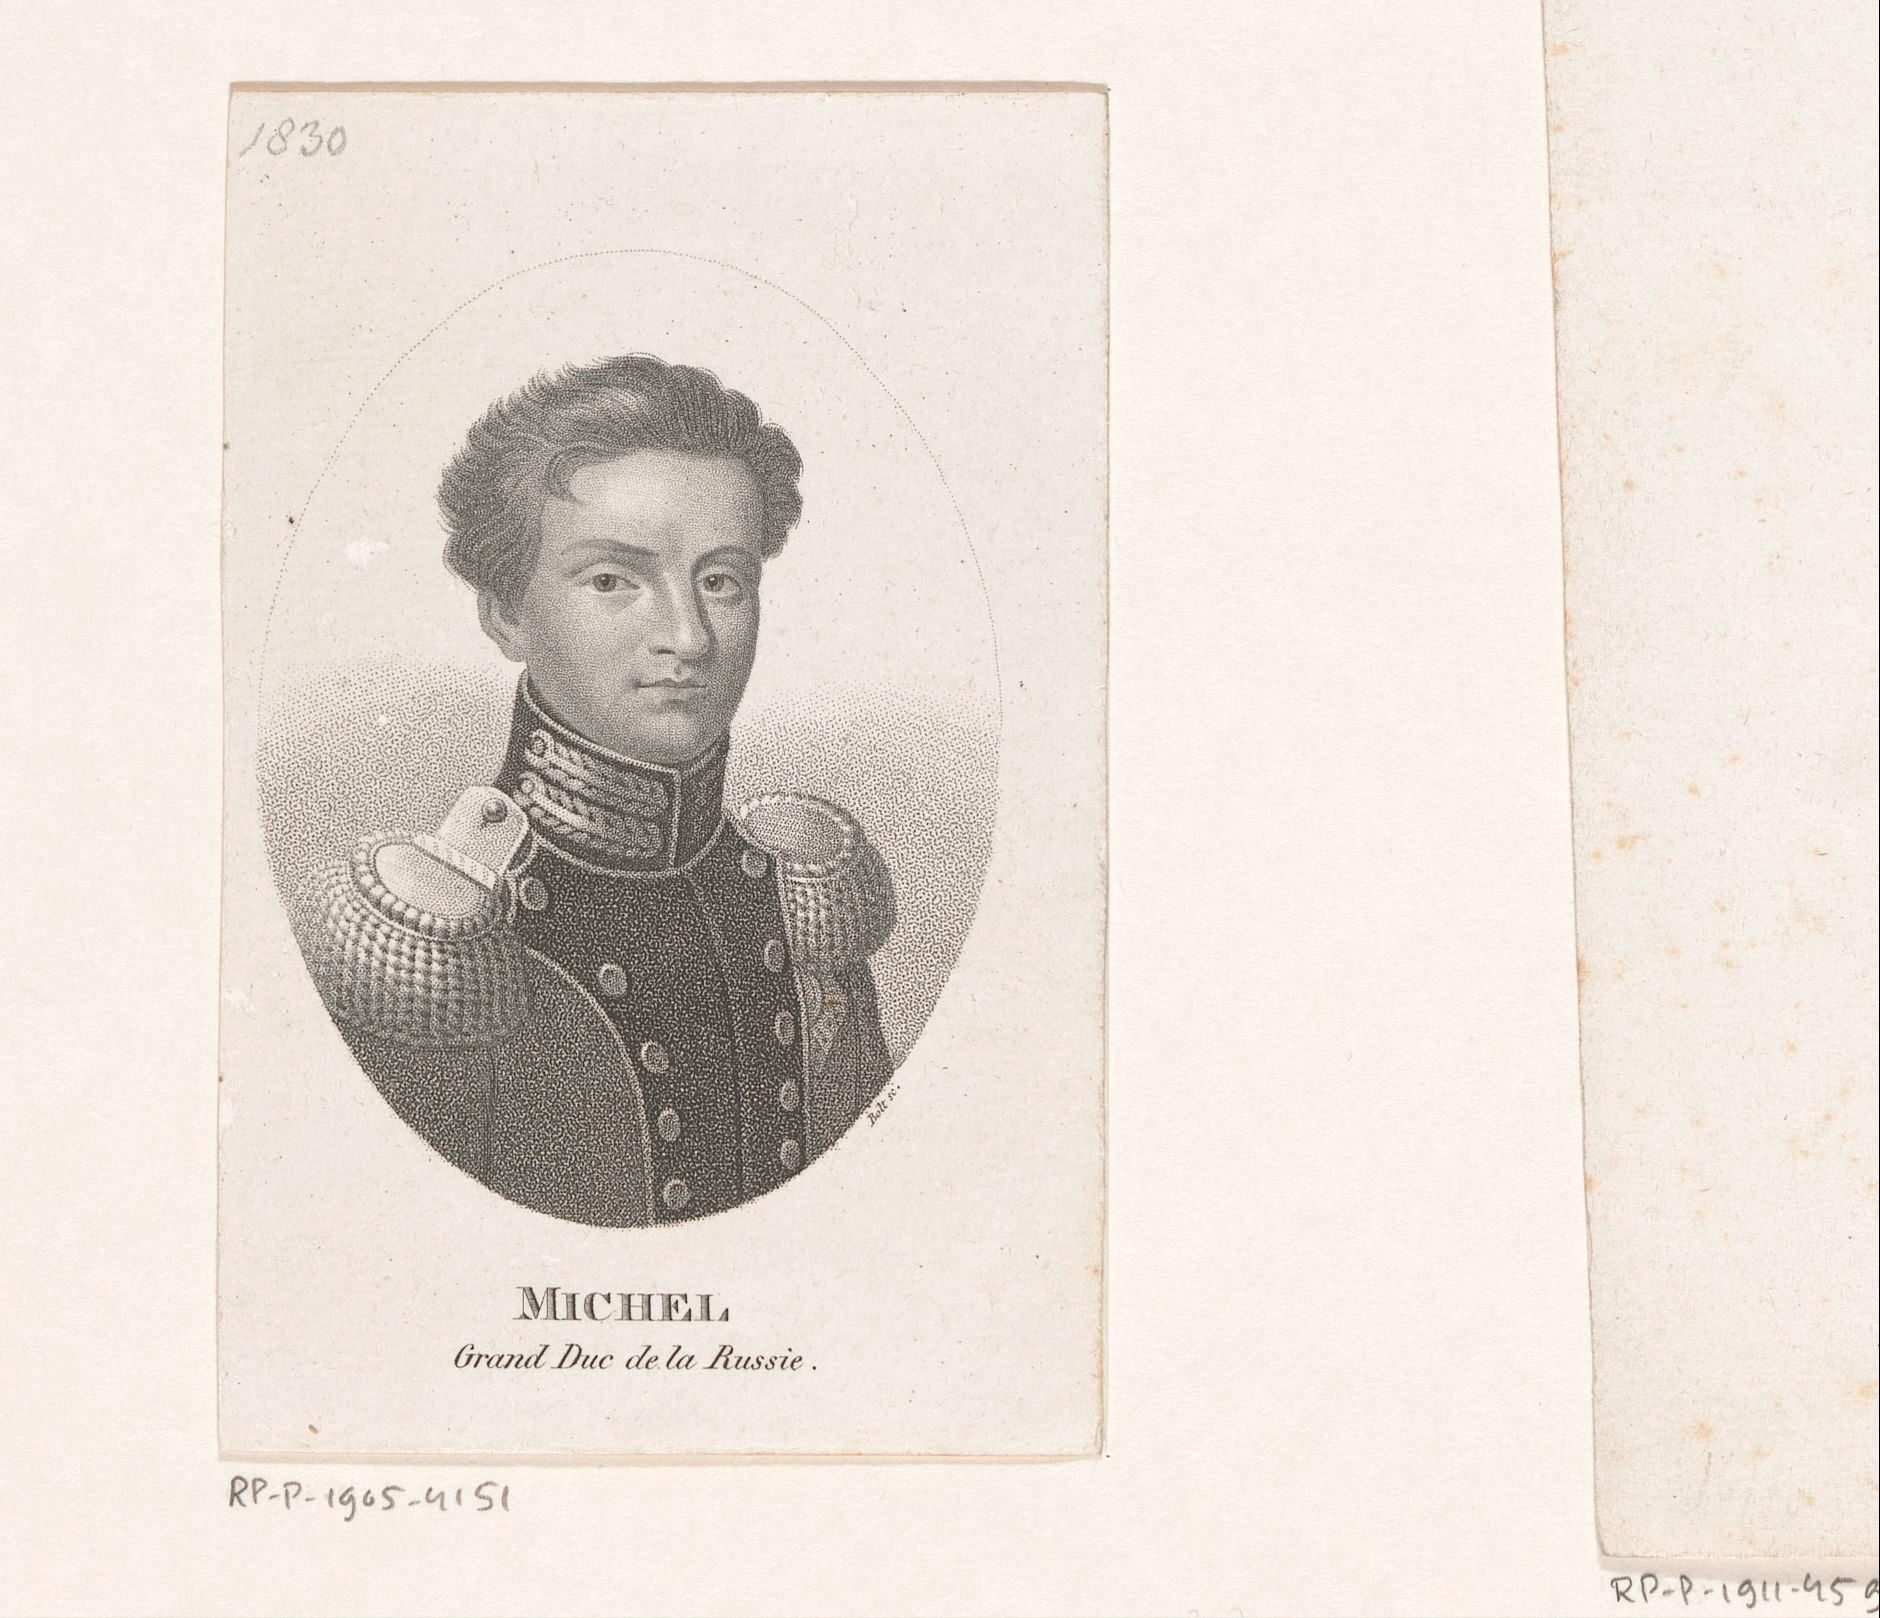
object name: print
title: Portret van Michaël Pavlovitsj, grootvorst van Rusland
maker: johann friedrich bolt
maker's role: print maker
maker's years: 1769-1836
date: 1830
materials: paper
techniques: stippling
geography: berlin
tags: historical persons, (military) uniforms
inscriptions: collector's mark: Lugt 2228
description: Prent mogelijk afkomstig uit: Almanach de Gotha, 1830.